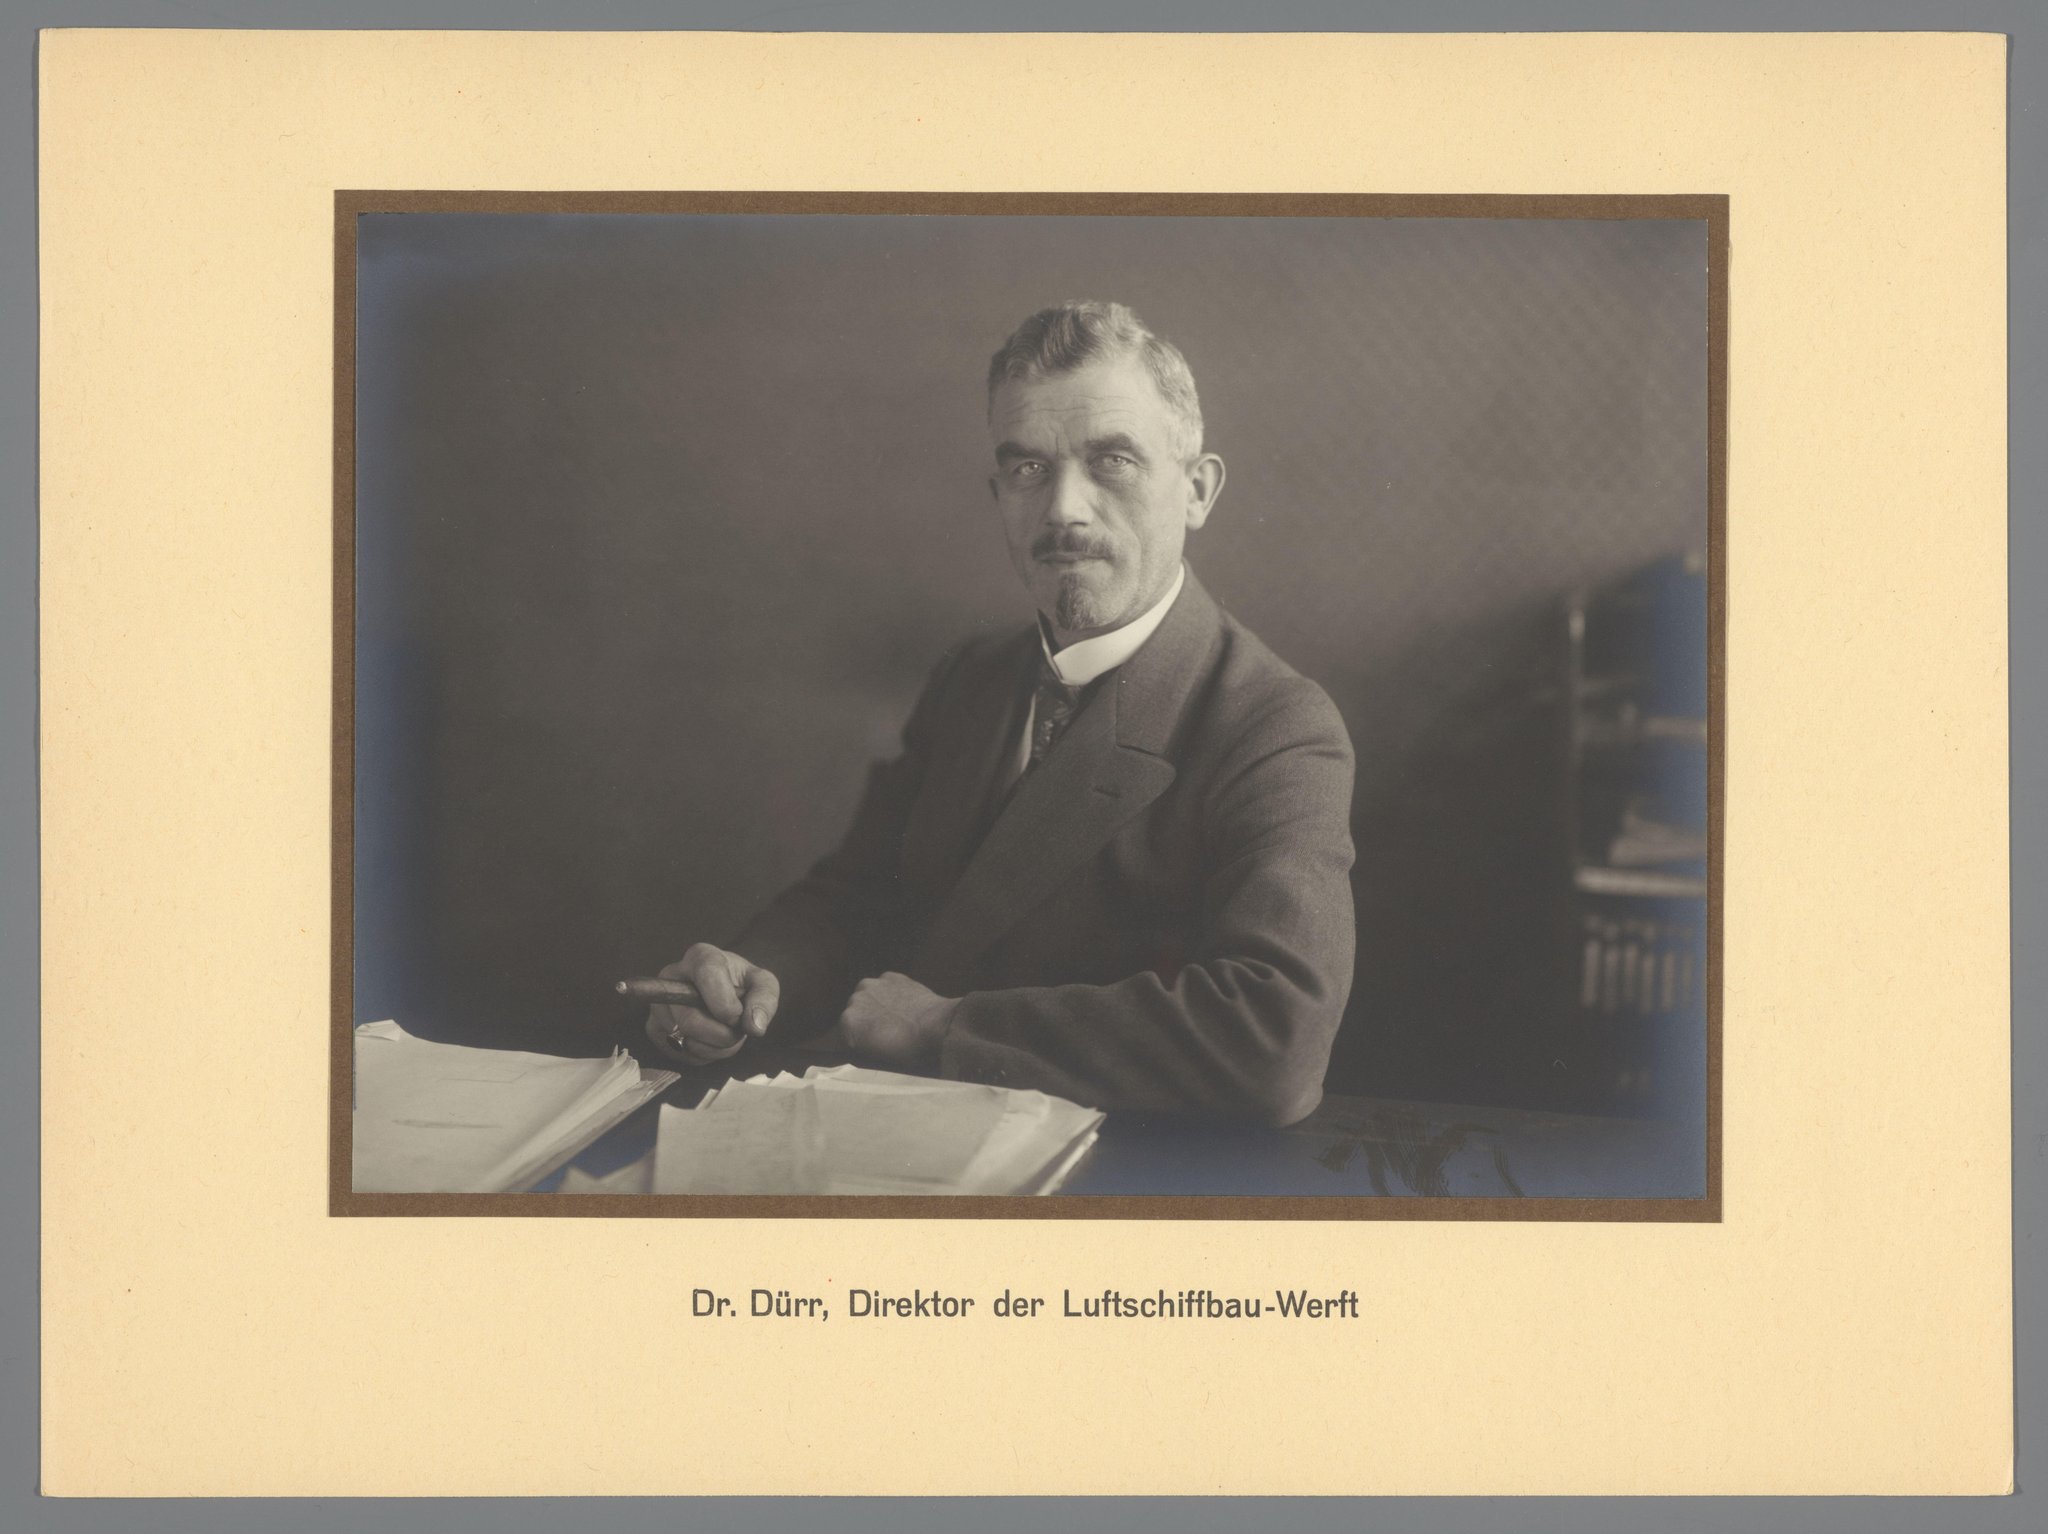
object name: photograph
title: Dr. Dürr, Direktor der Luftschiffbau-Werft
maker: Anonymous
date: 1924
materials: cardboard, photographic support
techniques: gelatin silver print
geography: friedrichshafen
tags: 46c35 airship, zeppelin, historical persons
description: Portret van directeur Dürr, zittend achter bureau. Onderdeel van een map twintig productfoto's van het Zeppelinluchtschip LZ 126.